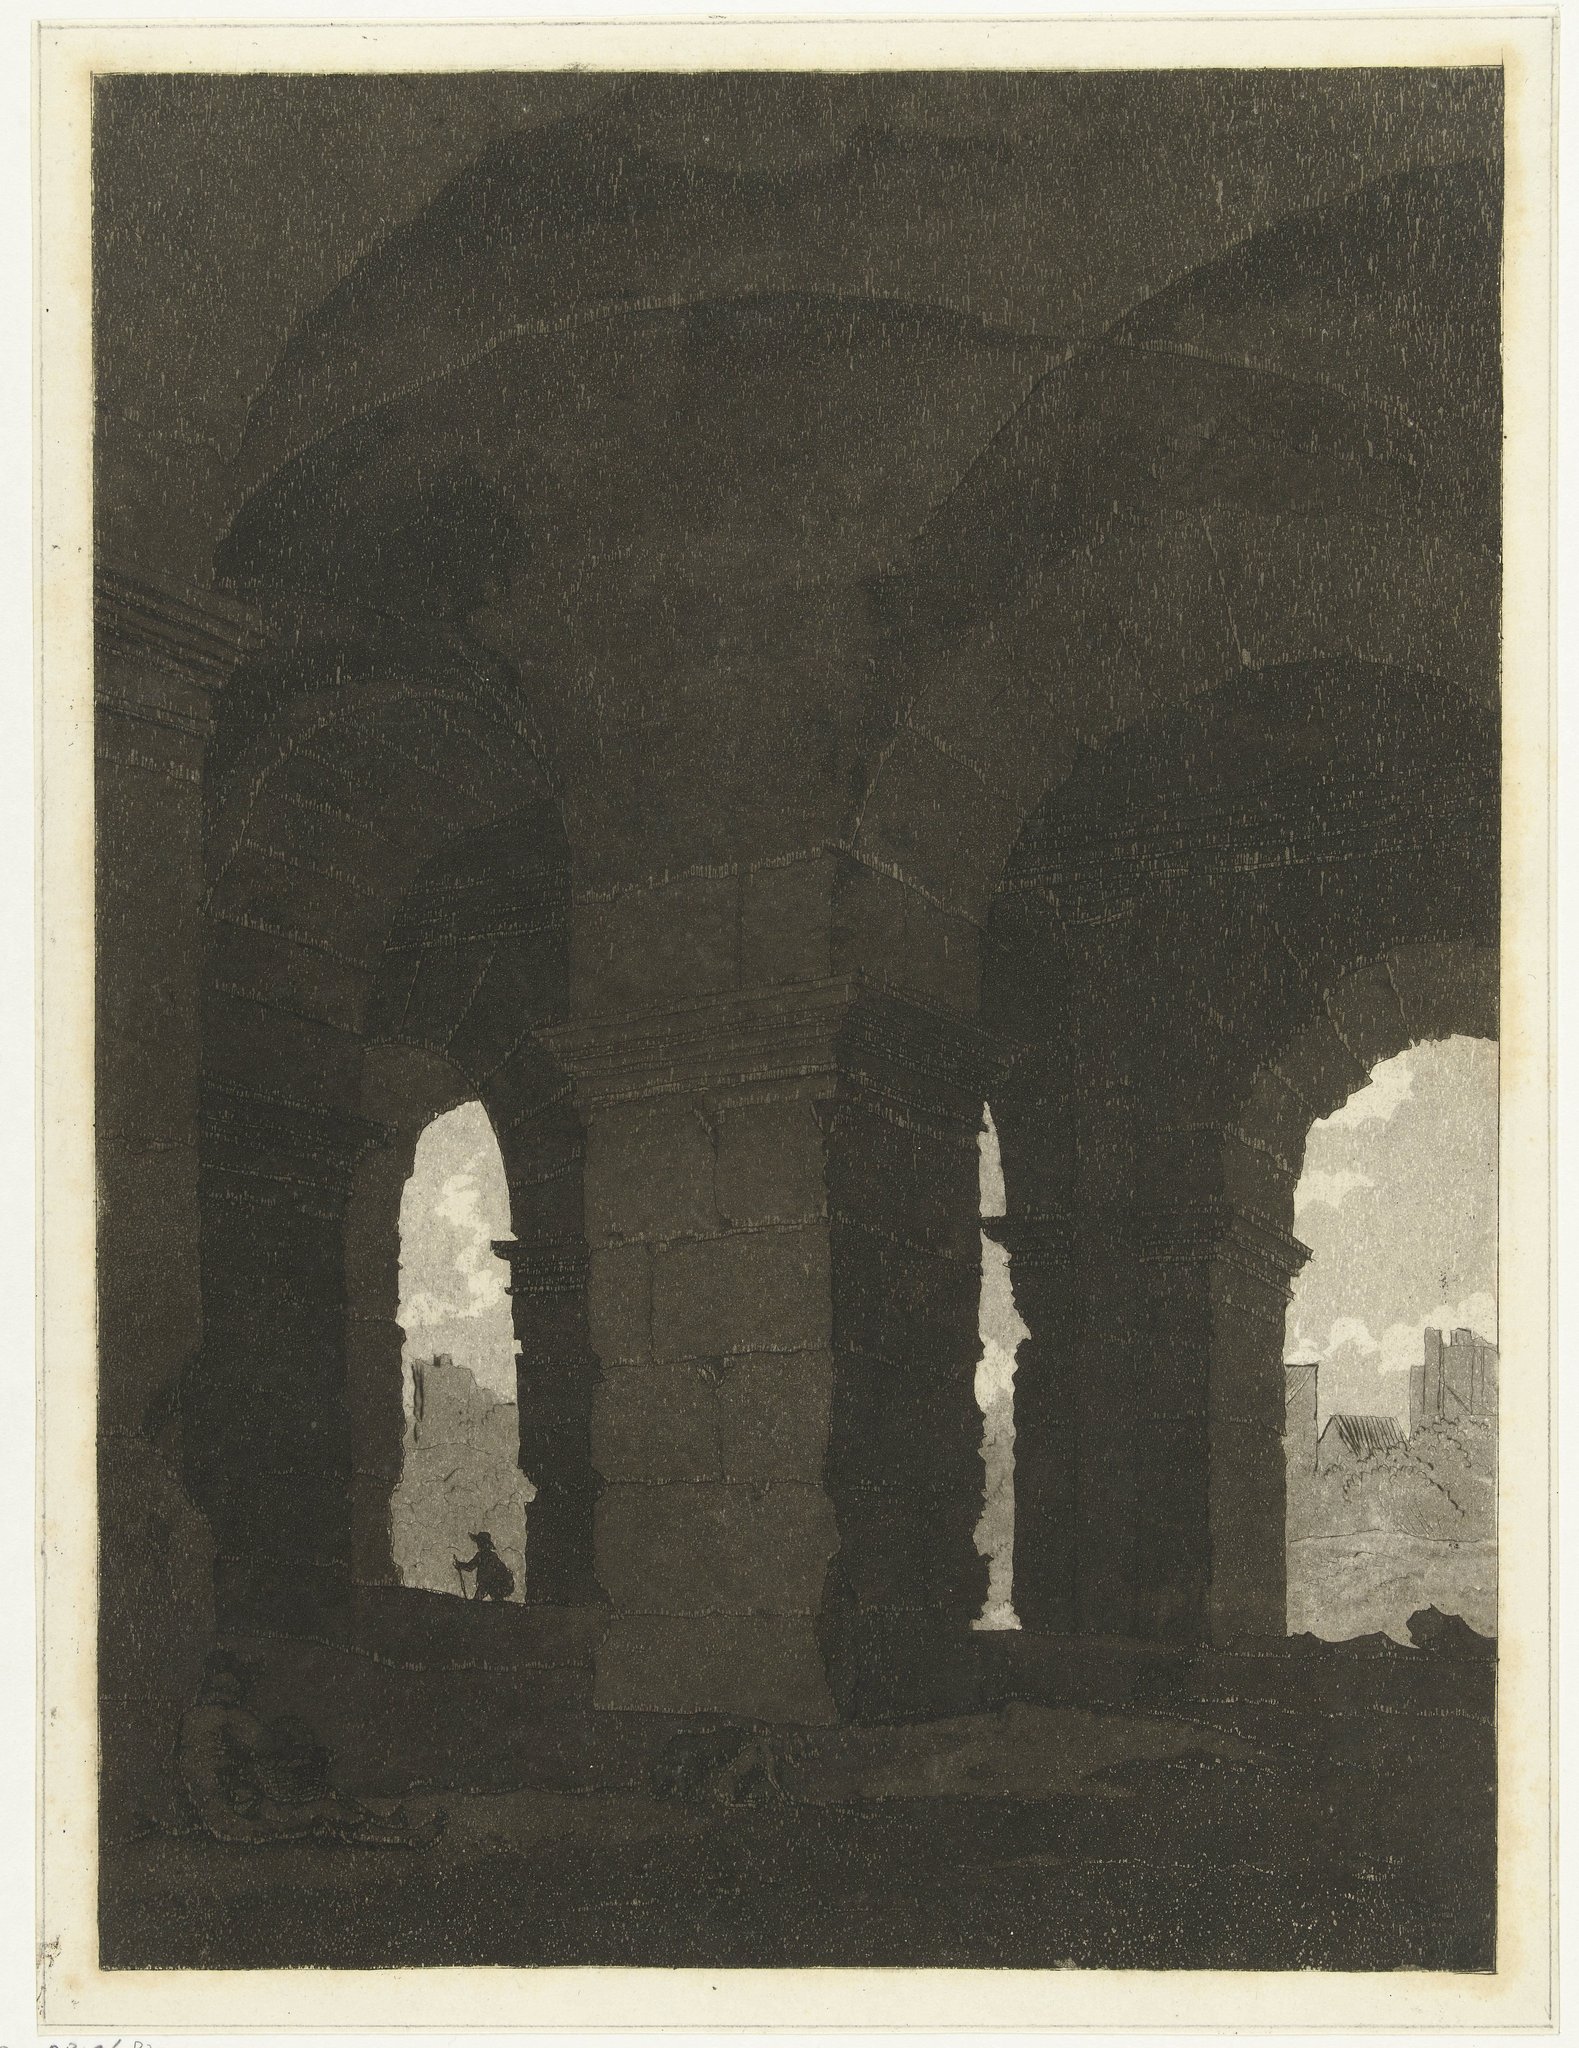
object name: print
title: Onder de bogen van het Colosseum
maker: anthonie van den bos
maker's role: draughtsman, print maker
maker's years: 1763-1838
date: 1778-1838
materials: paper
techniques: aquatint, etching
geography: netherlands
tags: arch, archivolt ~ architecture, shadow, vault ~ architecture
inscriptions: collector's mark: Lugt 2228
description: Een man zit tegen een pijler geleund in de schaduw van een booggalerij. Naast hem spelen twee honden.